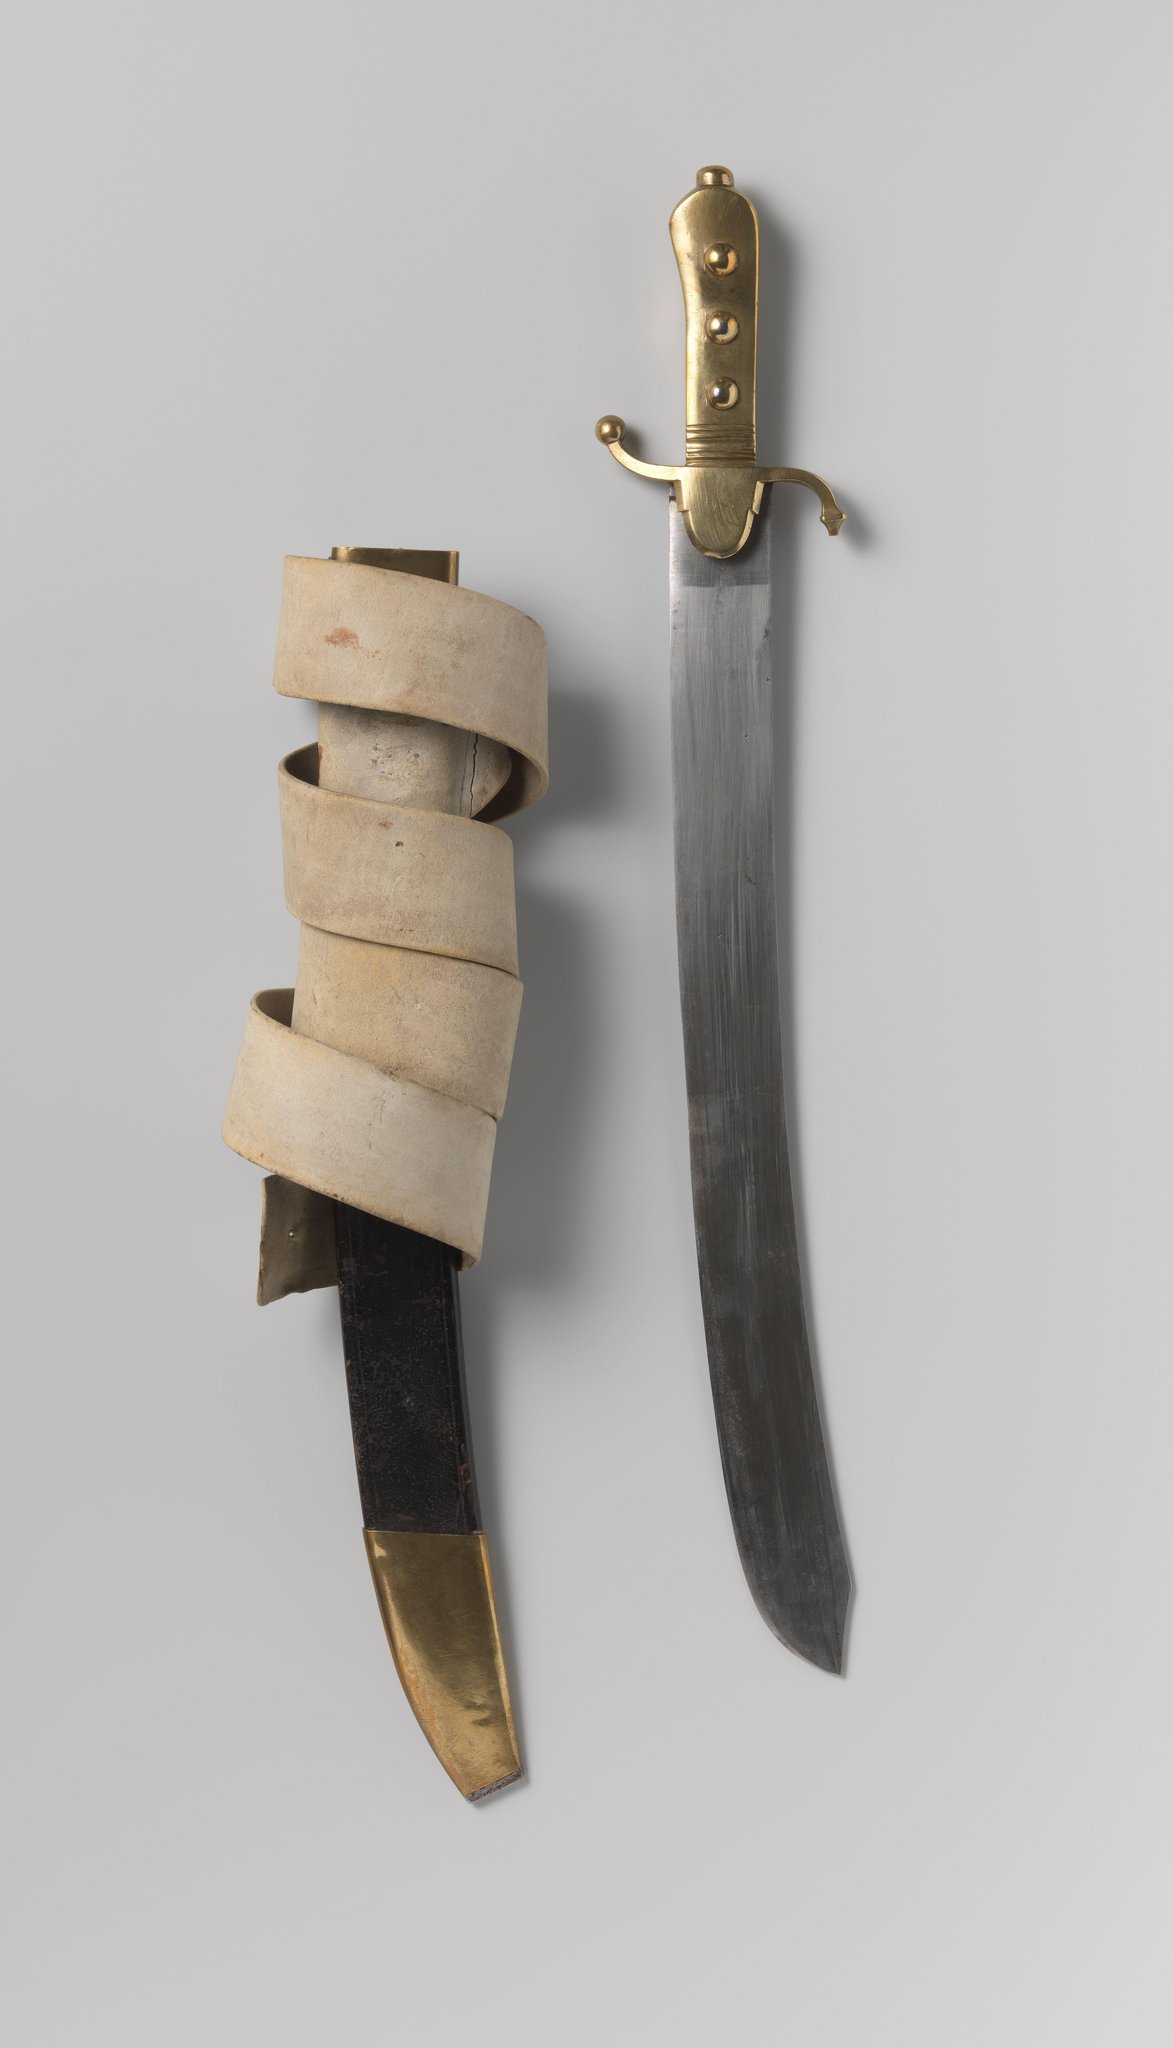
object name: sabre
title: Sappeurssabel met schede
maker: Anonymous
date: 1820-1832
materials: copper, iron, leather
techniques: cutting, forging, stitching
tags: amsterdam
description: Sappeurssabel ca. 1820, met schede en bandelier. Koperen gevest. Vijfvormige pareerstang met twee knoppen. Halfronde stootplaat, licht gekleurd. Eensnijdende ijzeren kling (deels geblauwd?). Zwart leren schede met koperen boven- en onderband. Aan de bovenband een koperen draagband, waaraan een wit leren bandelier met koperen gesp en wartel. Twee sleuven binnenzijde ingeslepen: 1825.